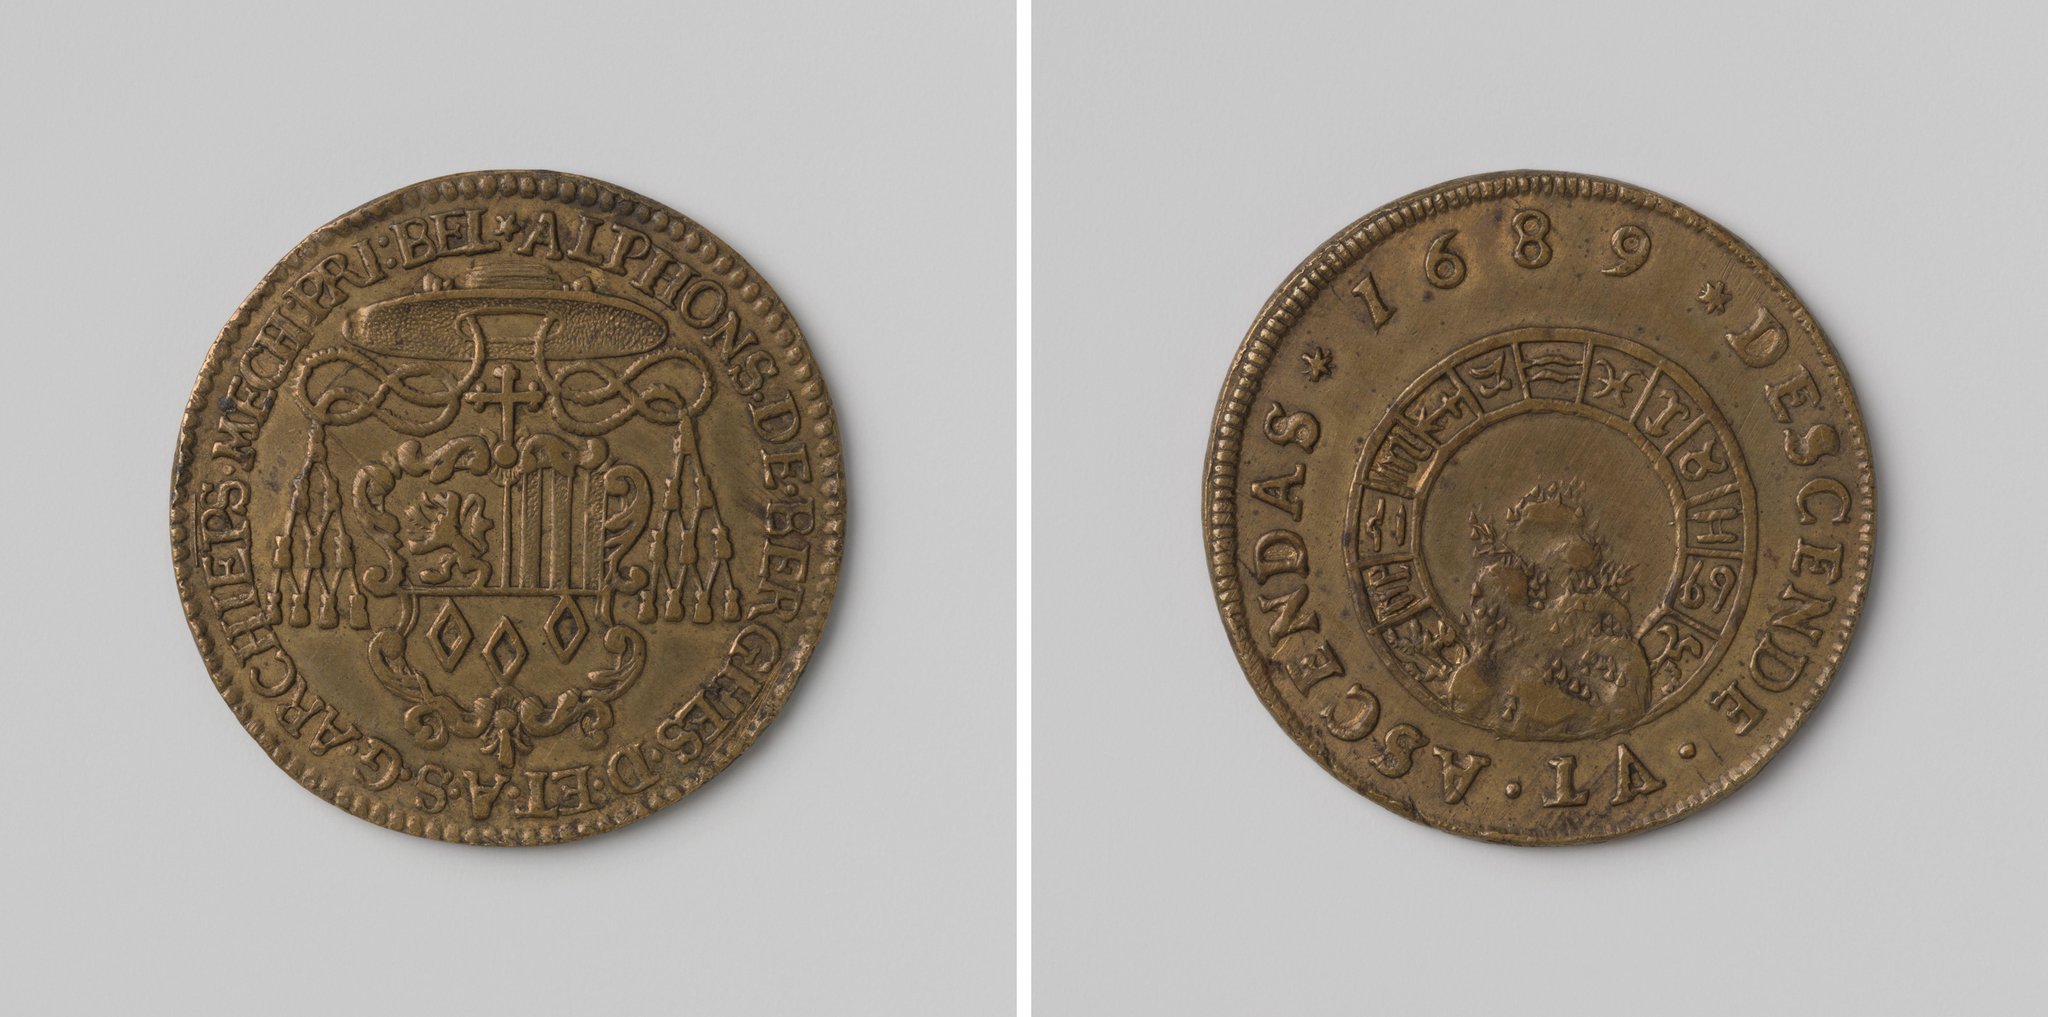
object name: jeton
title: Alphons van Bergen, aartsbisschop van Mechelen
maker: Anonymous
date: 1689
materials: copper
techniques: striking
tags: mechelen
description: Koperen penning. Voorzijde: wapenschild in cartouche onder aartsbischoppelijke hoed binnen omschrift. Keerzijde: hoge berg, omgeven door dierenriem binnen omschrift